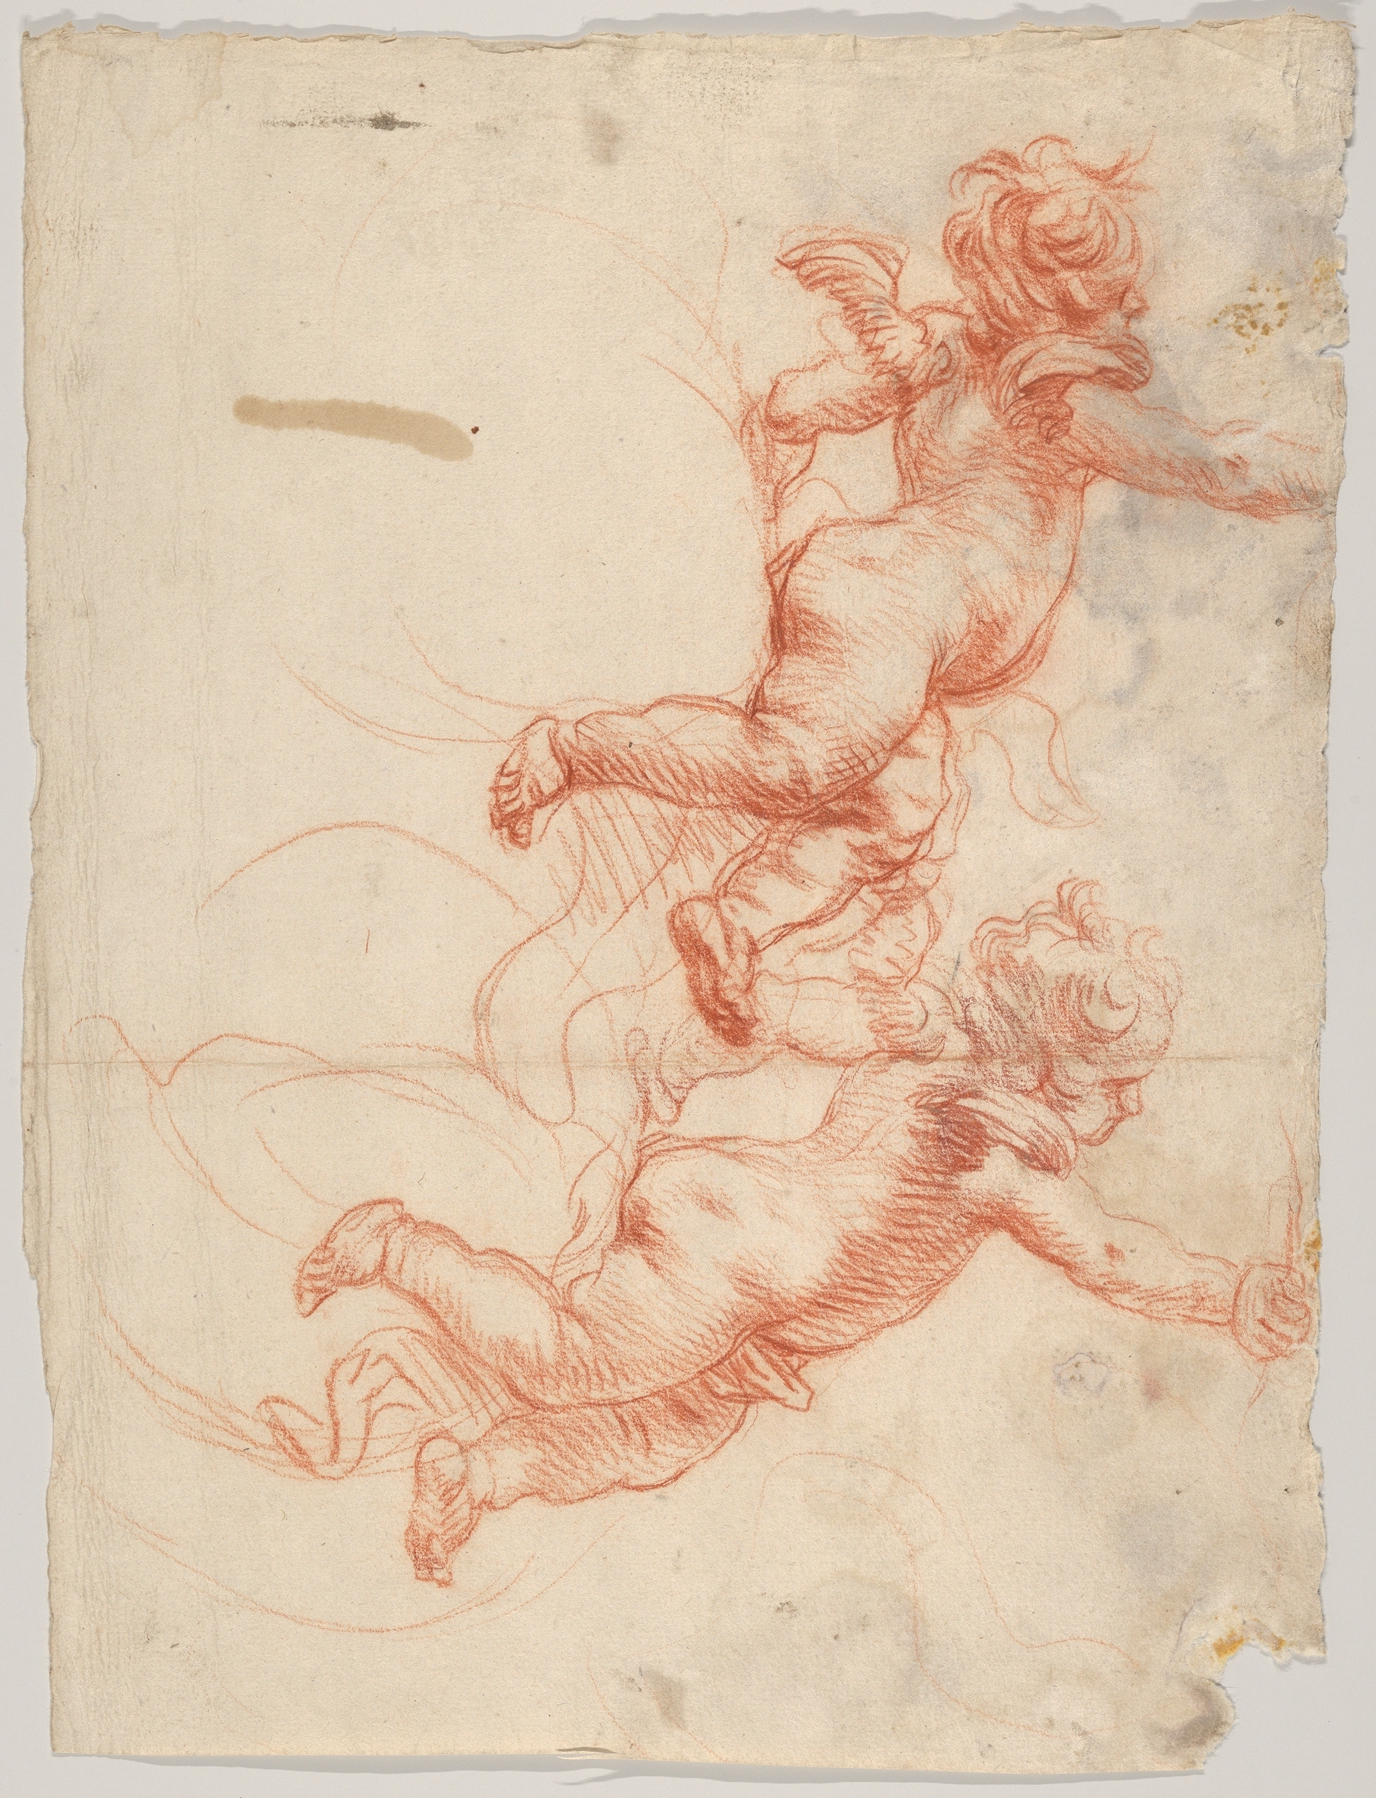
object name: drawing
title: Two Studies of a Flying Putto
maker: cornelis schut (i)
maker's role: artist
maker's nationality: flemish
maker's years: 1597-1655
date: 1634-1666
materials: chalk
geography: belgium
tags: putti